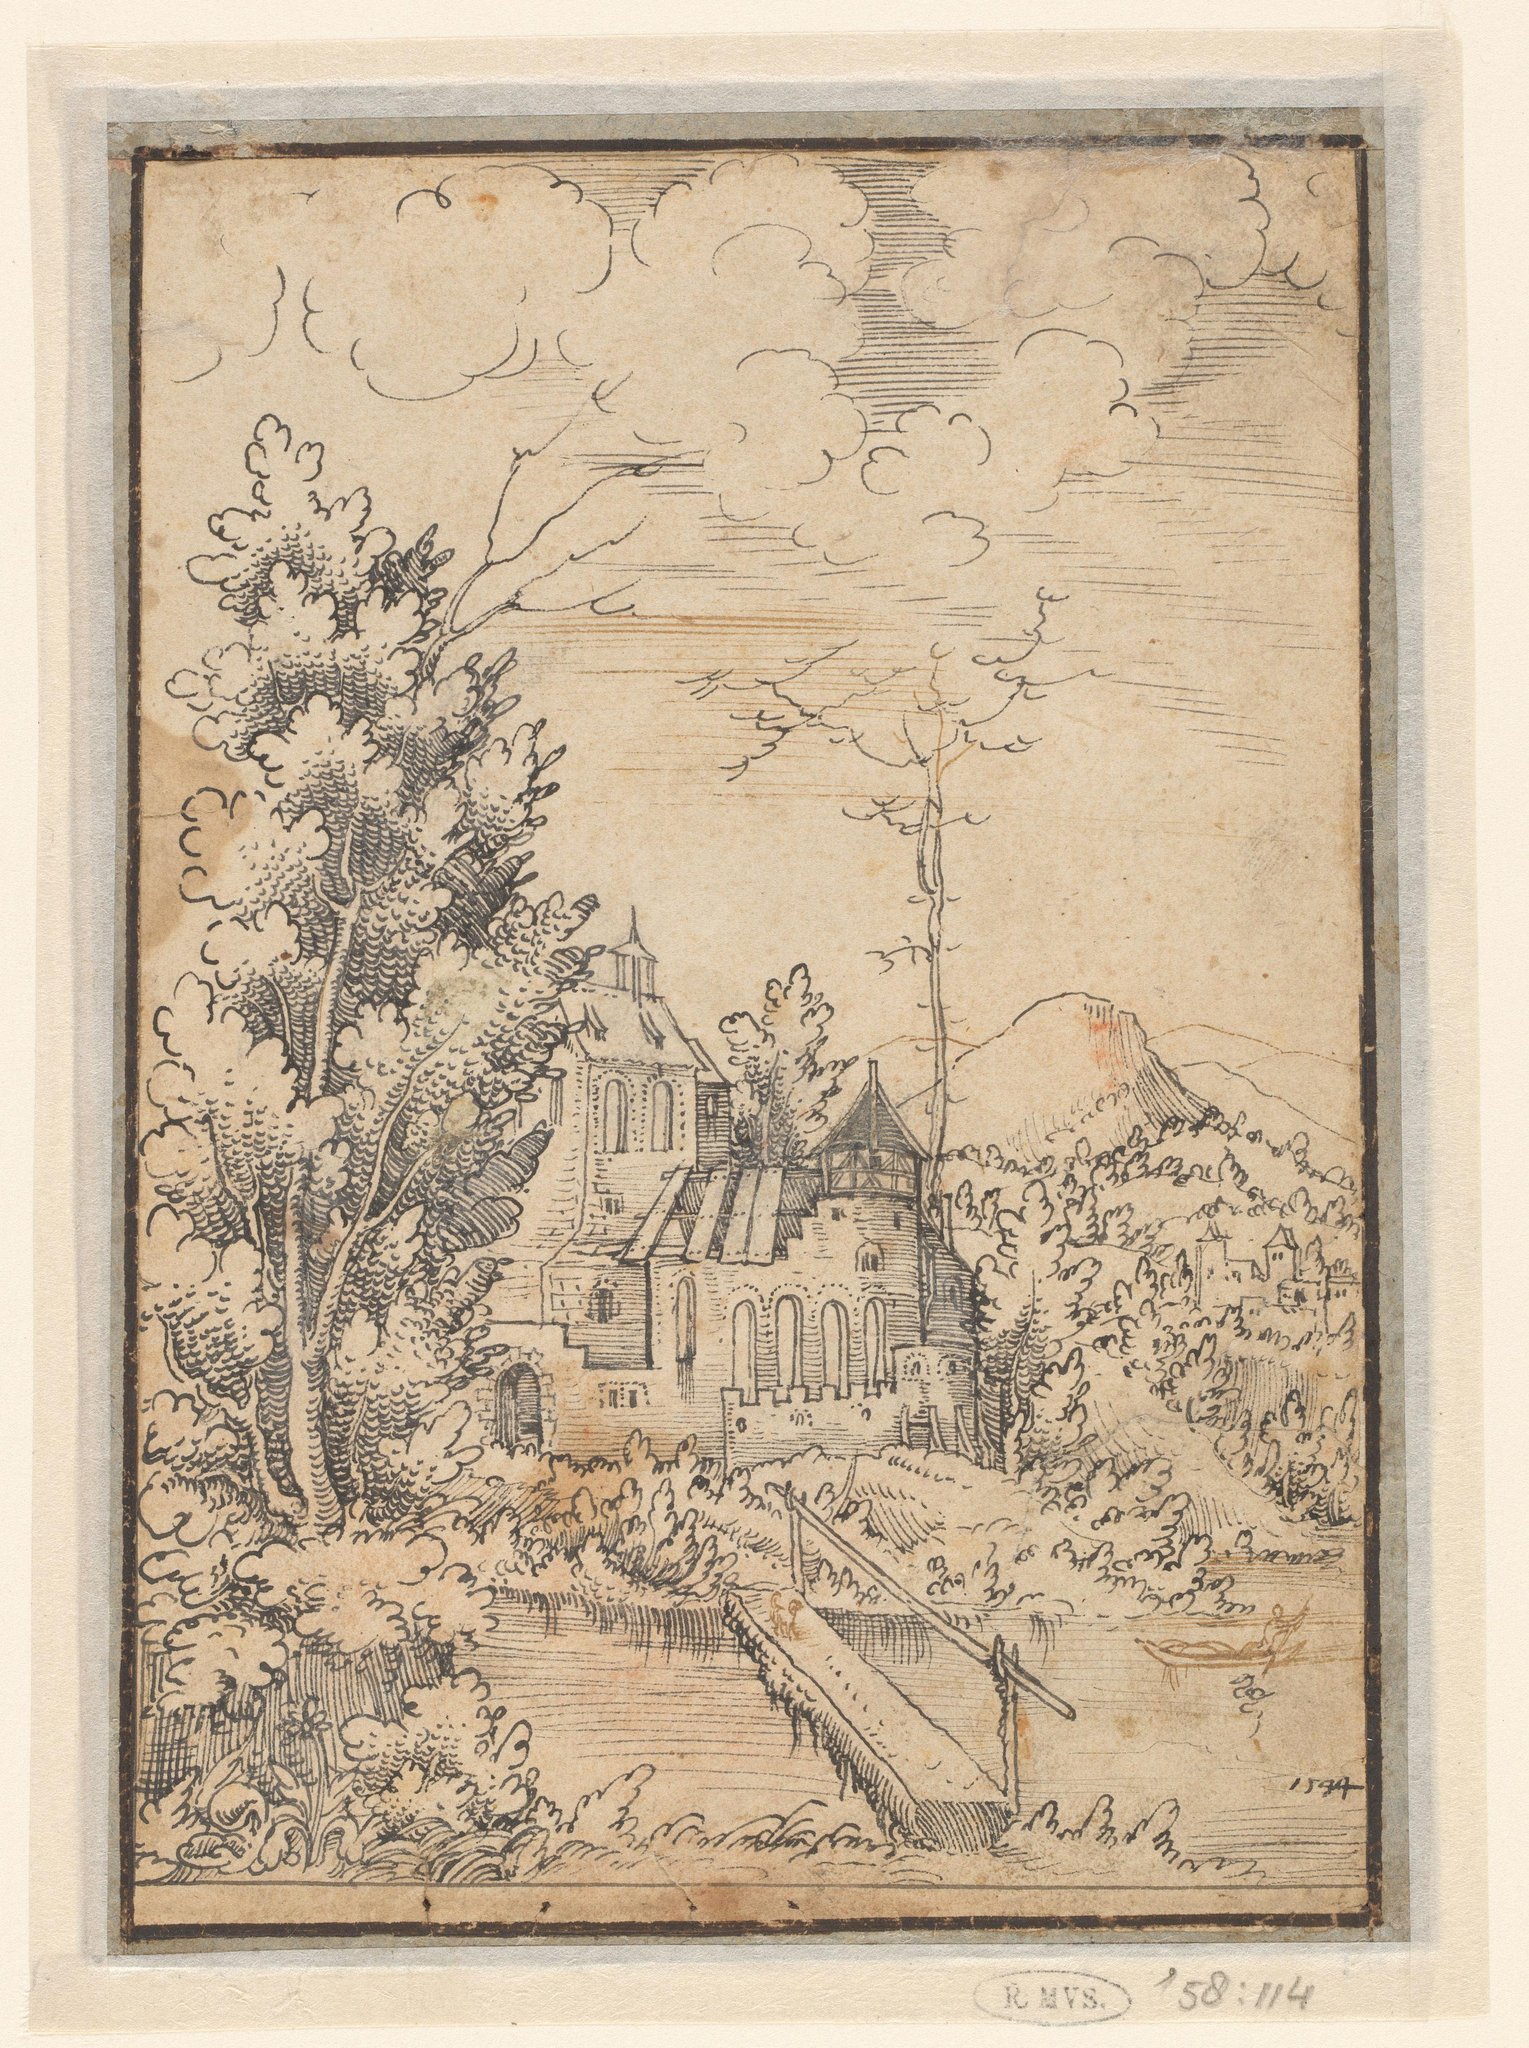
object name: drawing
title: Kasteel bij een rivier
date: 1544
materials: ink, paper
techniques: pen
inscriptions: date: ‘1544’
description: Kasteel aan de overzijde van een rivier; ervoor een houten brug.